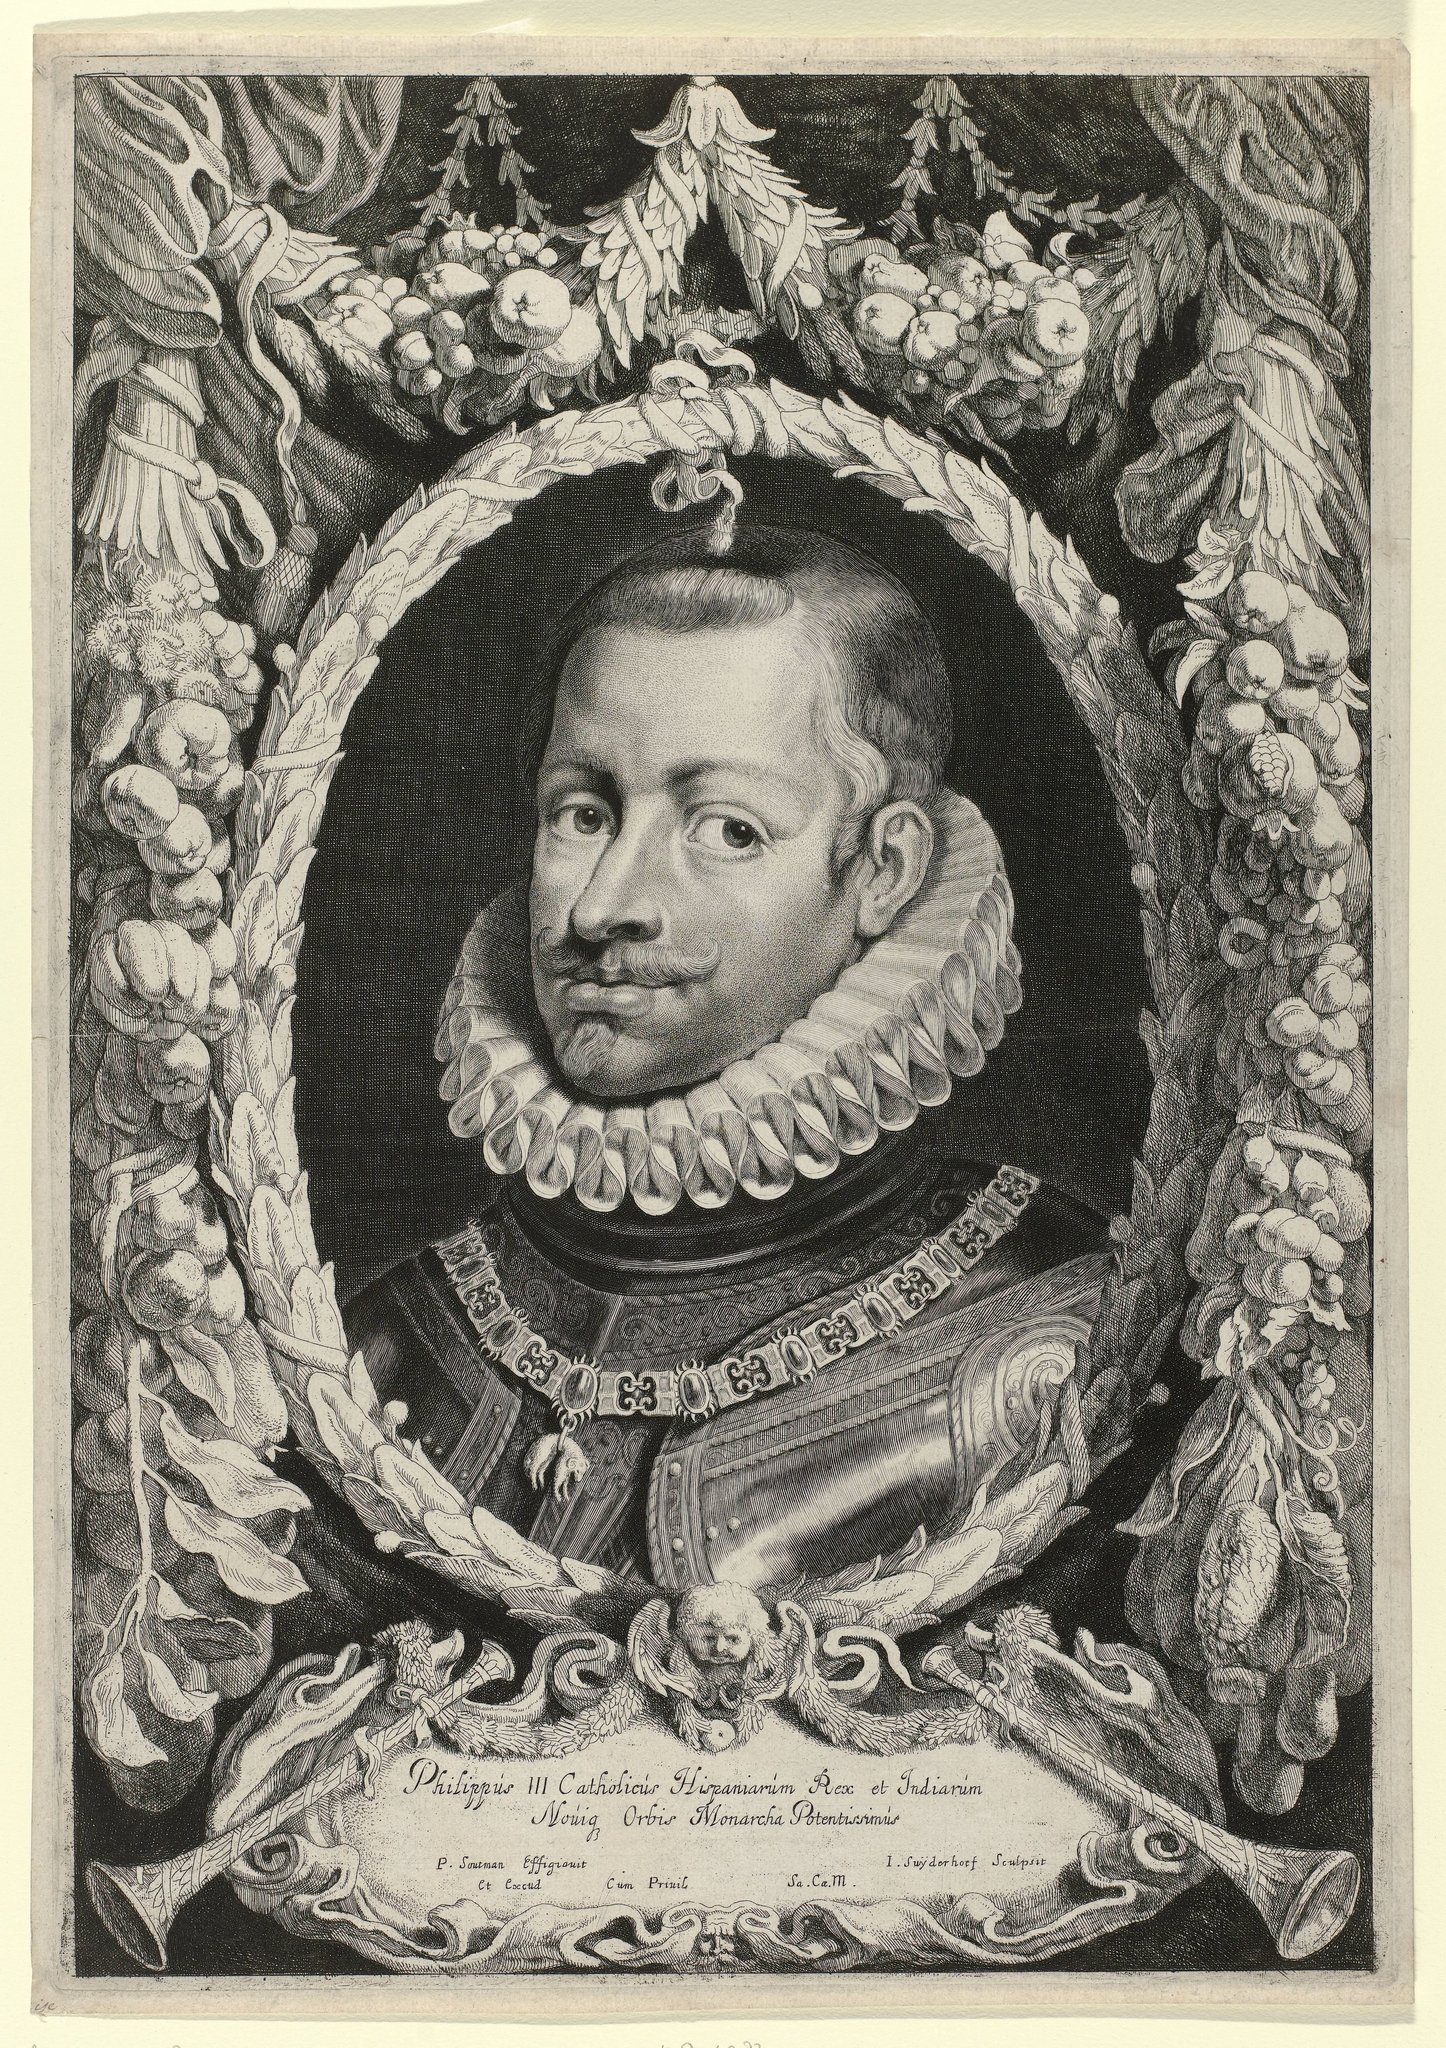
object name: print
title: Portret Filips III, koning van Spanje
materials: paper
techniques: engraving, etching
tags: filips iii (koning van spanje)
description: Buste naar links, in lauwerkrans omgeven door ornament van guirlandes van vruchten en bloemen. Middenonder cartouche geflankeerd door twee bazuinen.